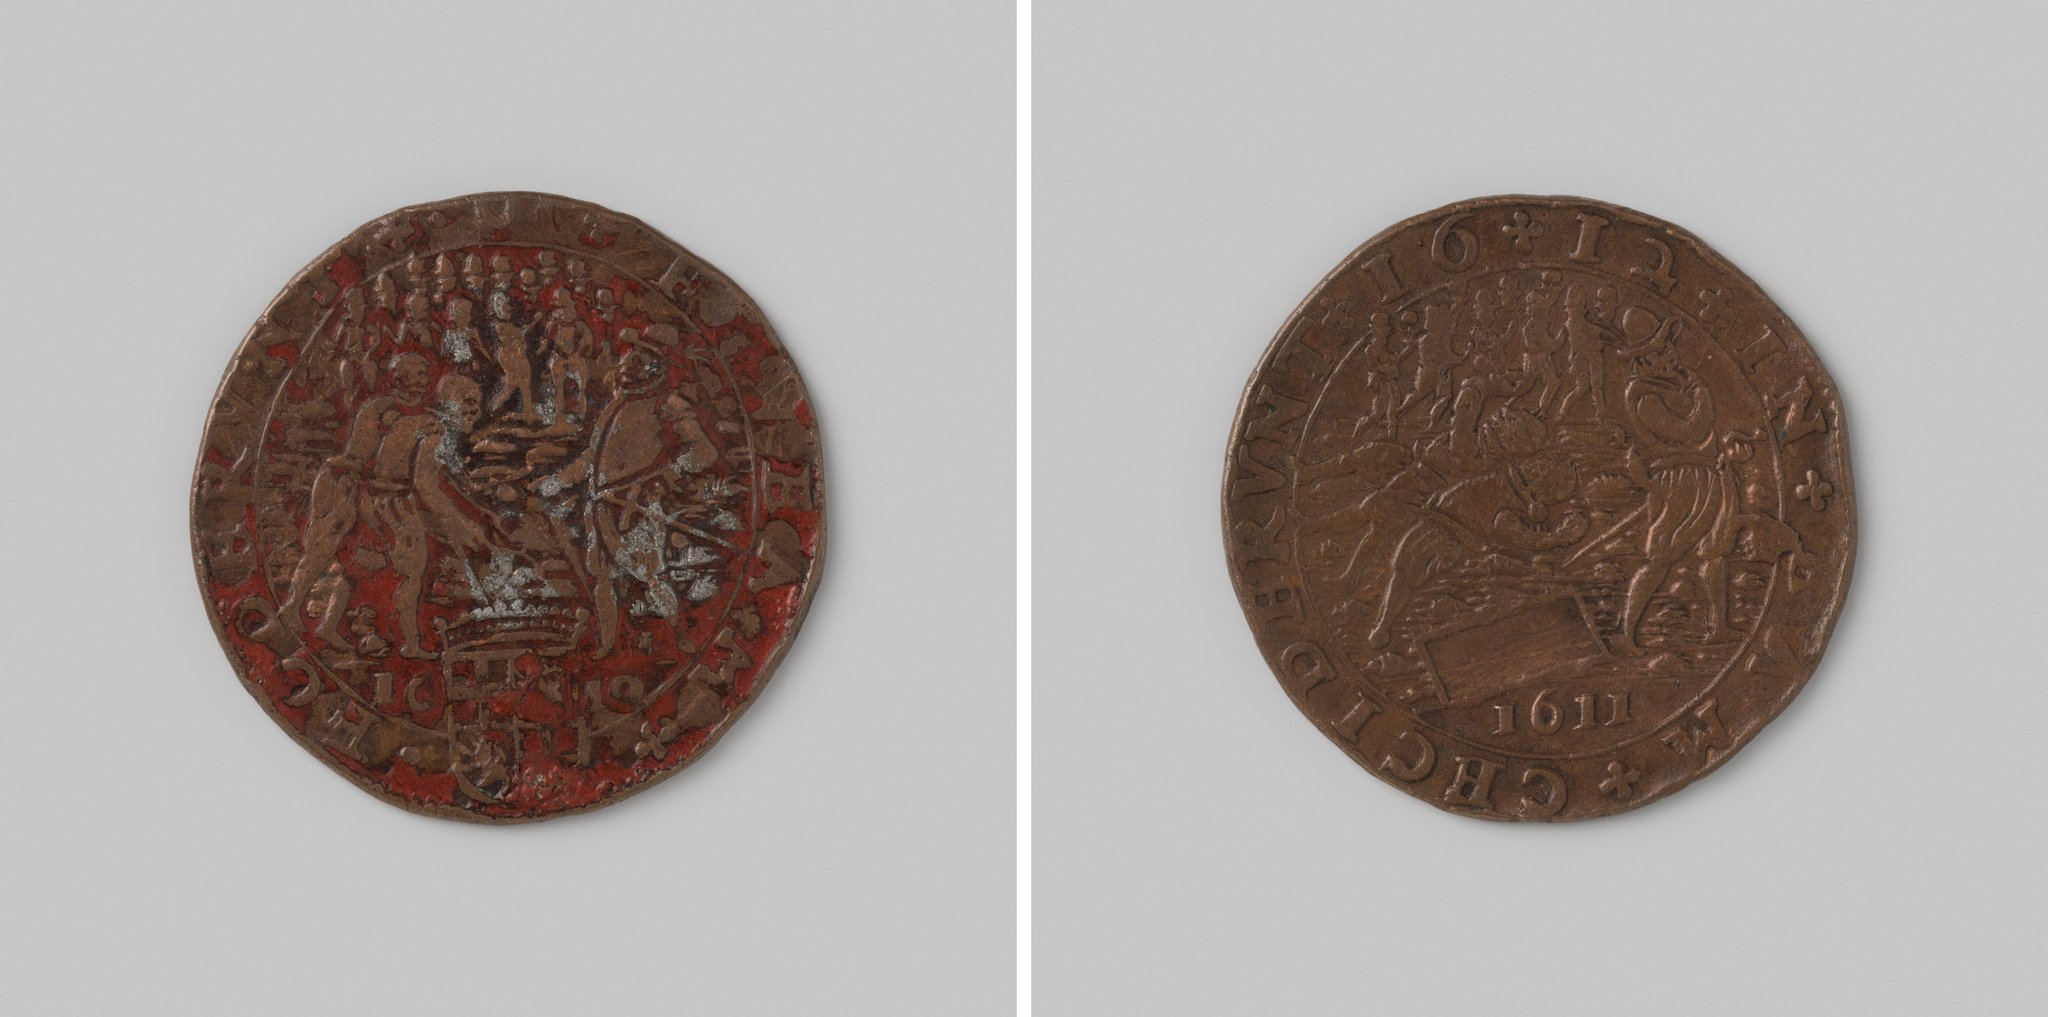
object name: history medal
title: Rekenpenning uit Utrecht op de onlusten in Utrecht 1612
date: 1612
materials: copper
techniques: striking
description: Koperen penning, op de voorzijde onlustzaaiers (Dirk Kanter en Hendrik van Helsding) die een kuil graven, met omschrift, op de keerzijde de onlustzaaiers die in de kuil vallen, met omschrift.